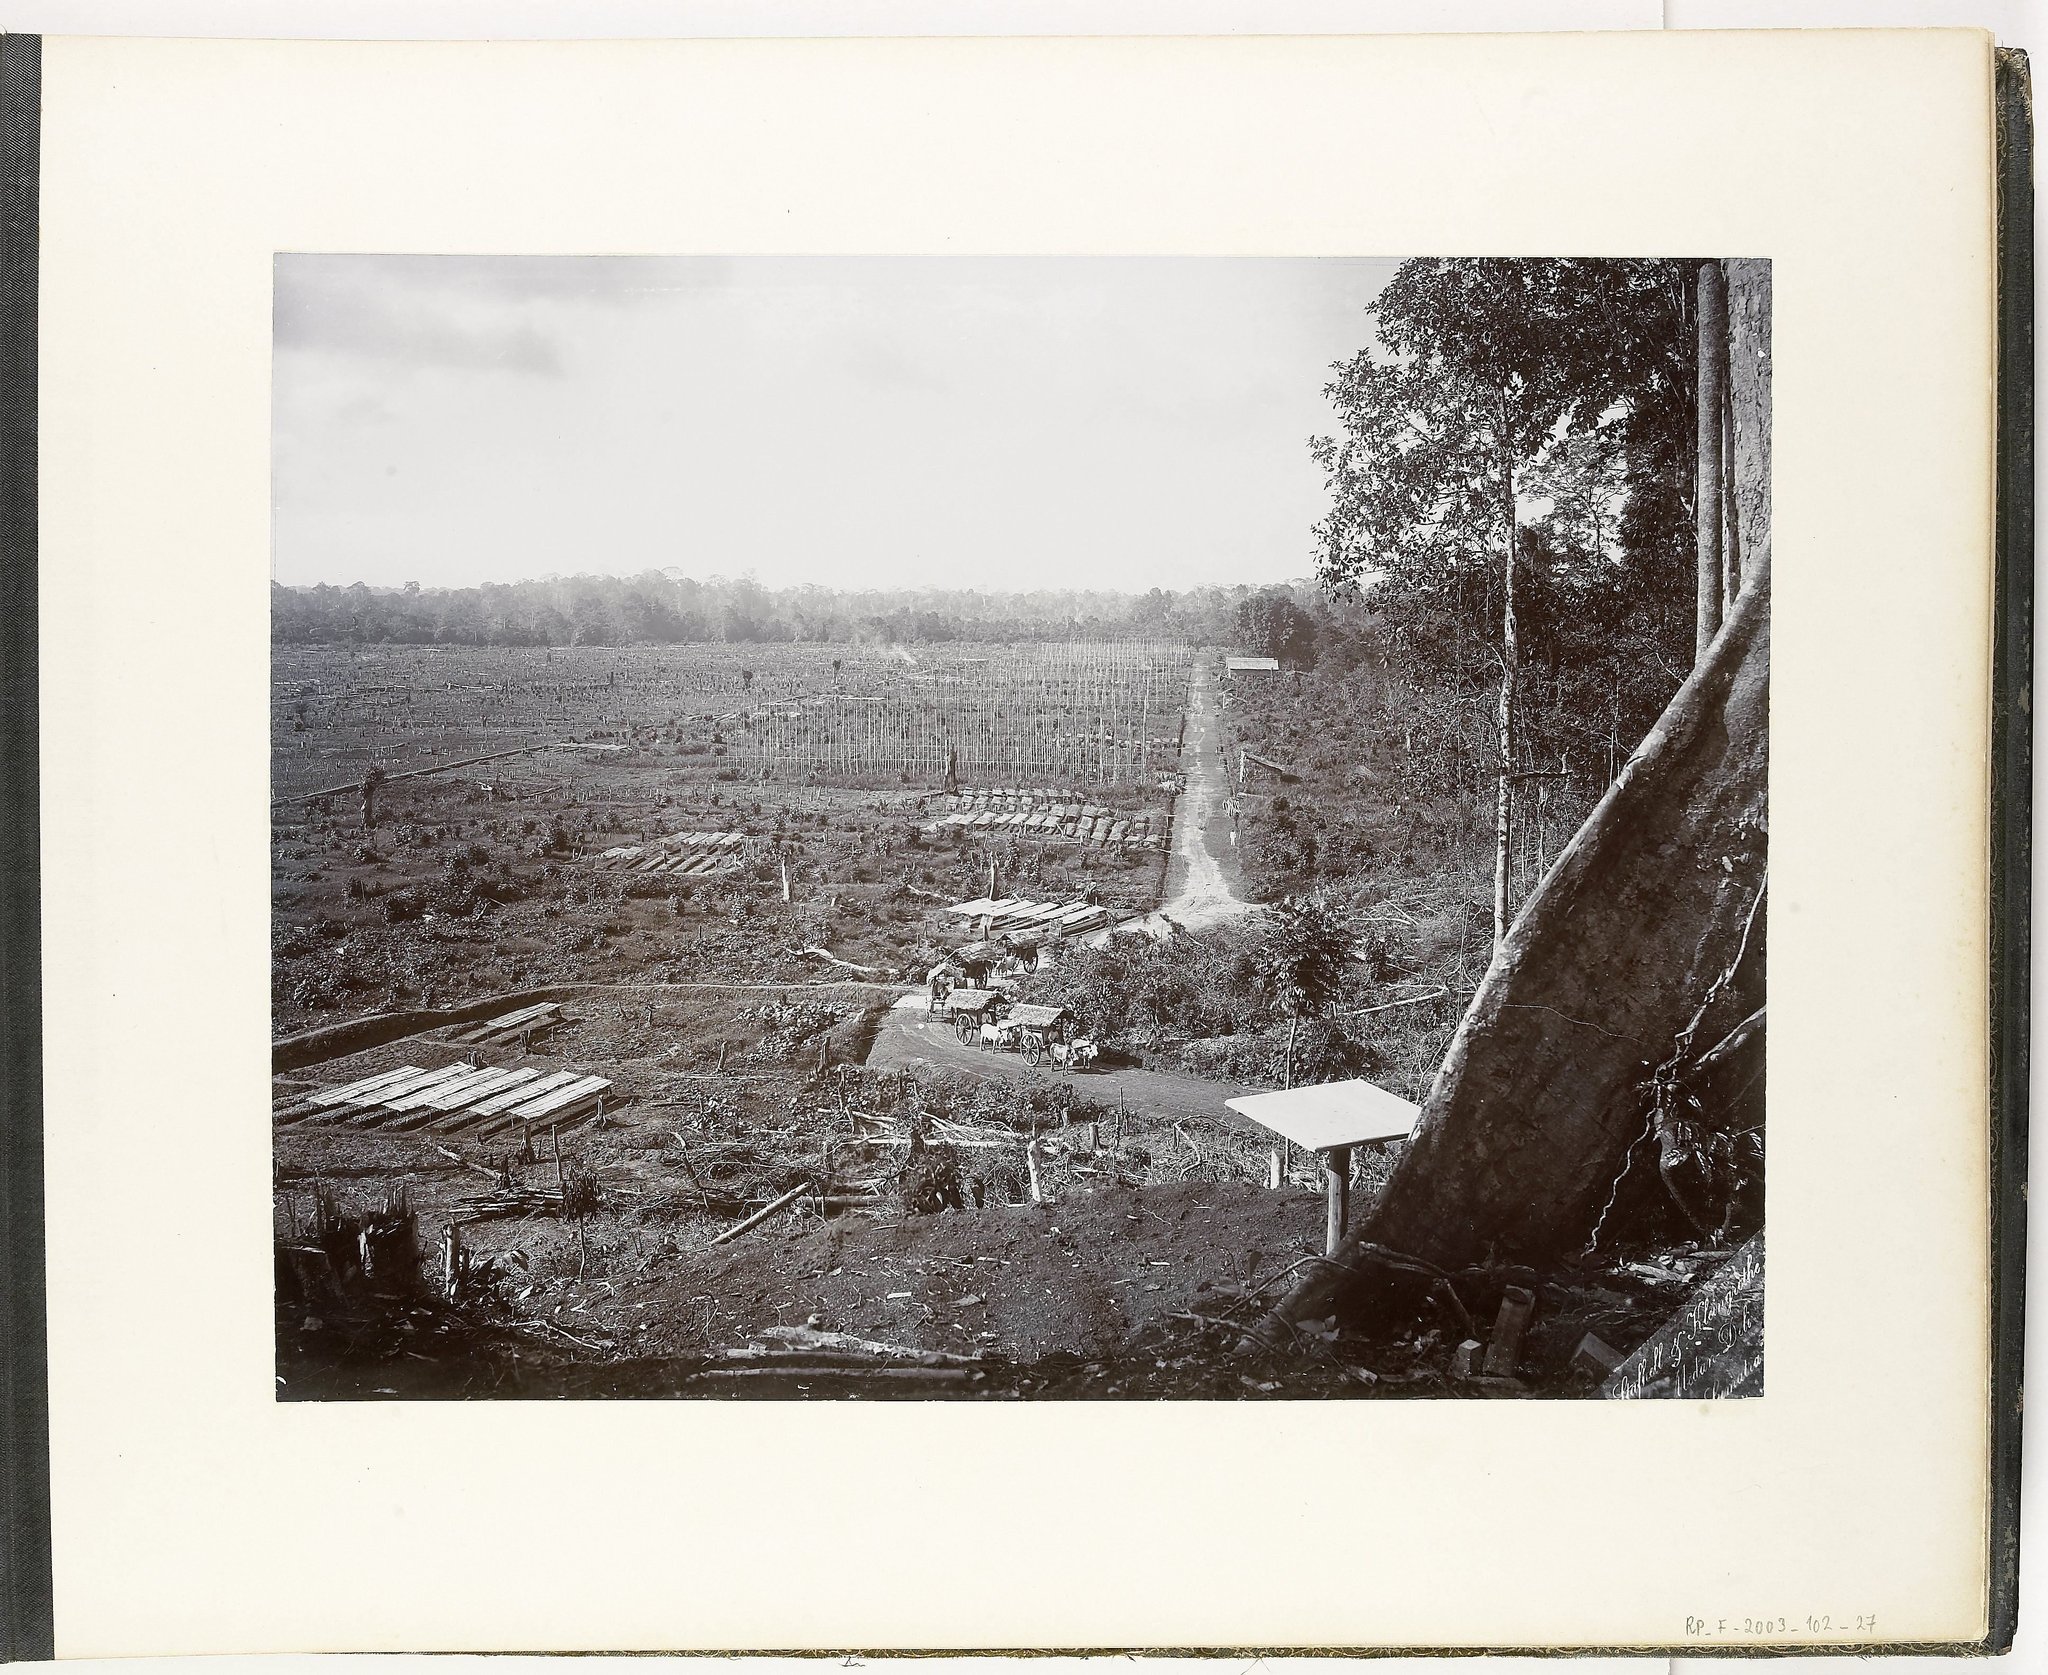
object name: photograph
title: Gezicht op de zaaivelden van een plantage bij Soekaranda, Sumatra (Saatfelder Soekaranda)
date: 1890-1900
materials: photographic support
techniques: collodion silver print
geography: sumatra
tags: sumatra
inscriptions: signature: ‘Stafhell & Kleingrothe Medan-Deli’, number: ‘Sumatra ...’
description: Gezicht op de zaaibedden en kweekvelden van een tabaksplantage bij Sukaranda op Sumatra. Onderdeel van het Sumatra fotoalbum van Paul en Lucie Sandel uit 1900.